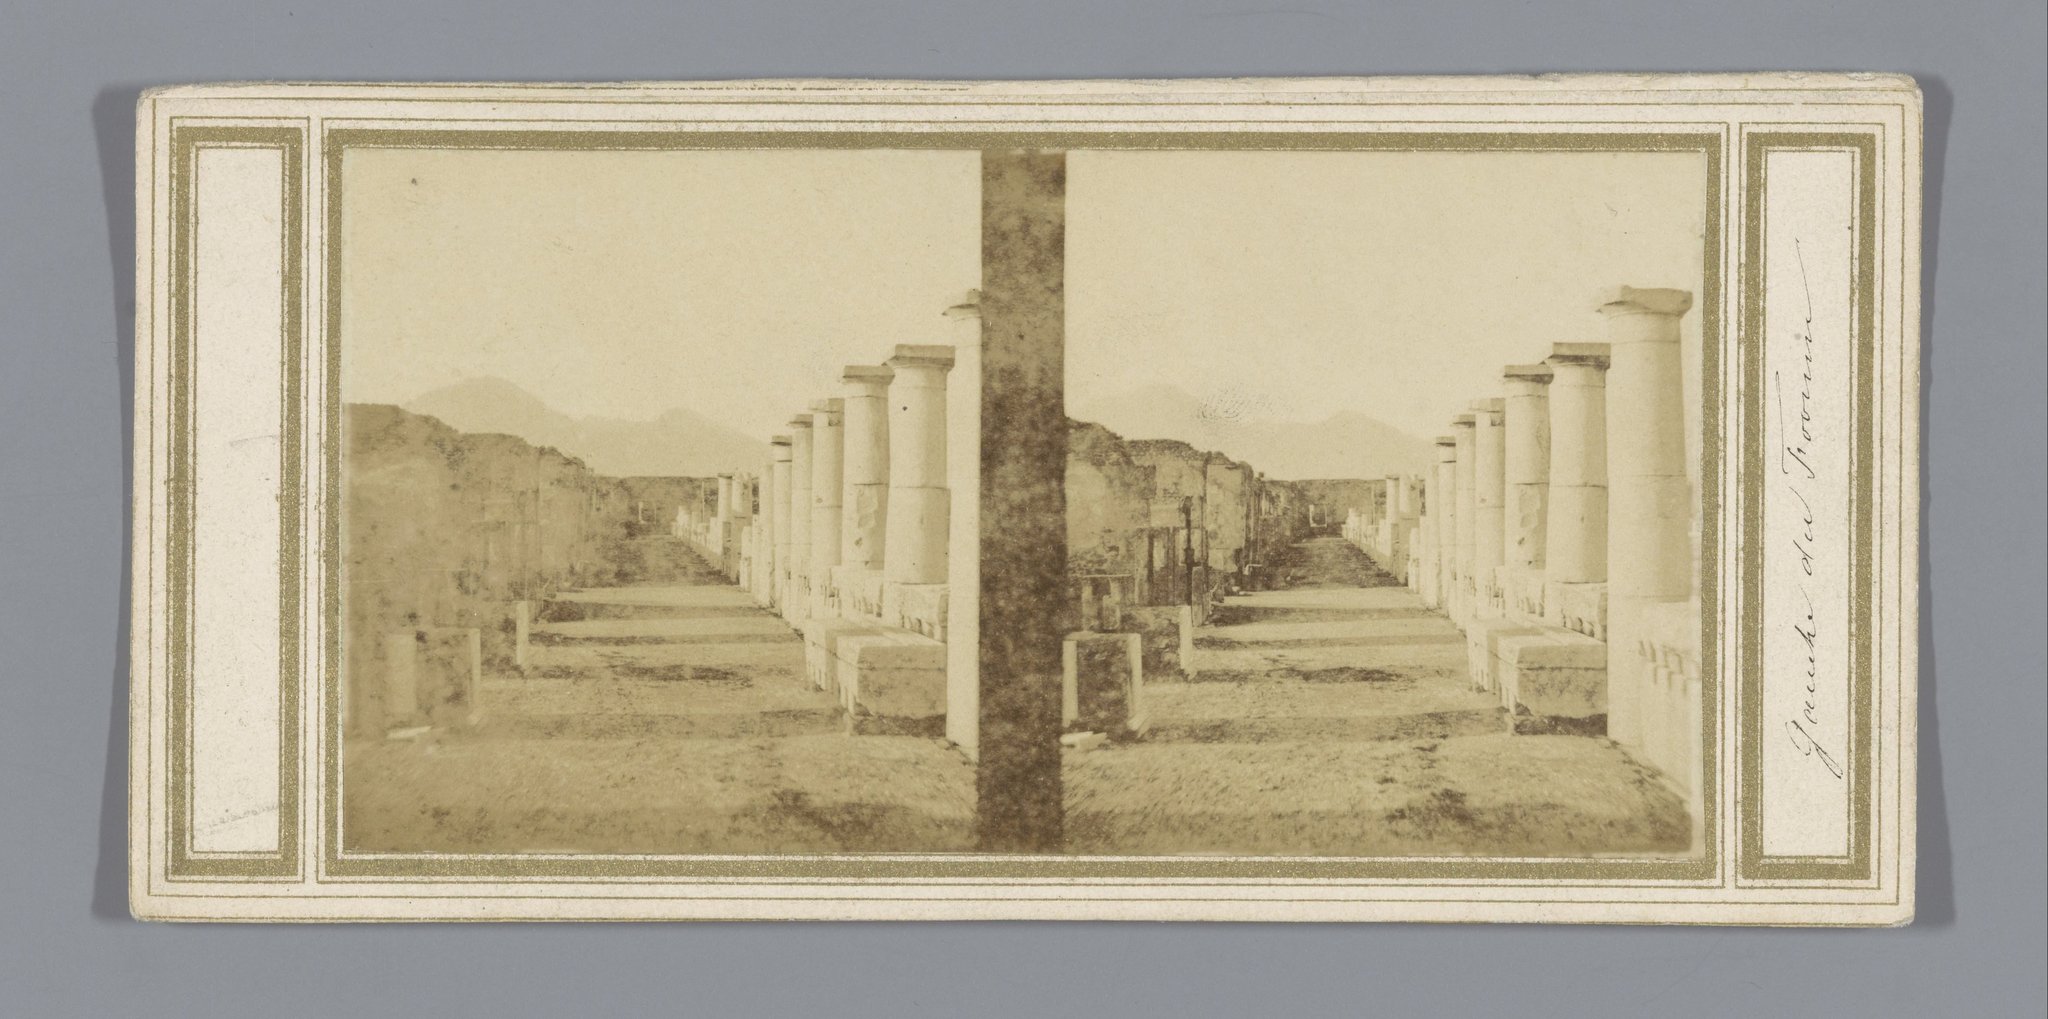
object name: stereograph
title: Zuilenrij (vermoedelijk) te Taormina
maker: Anonymous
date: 1850-1880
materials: cardboard, photographic support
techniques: albumen print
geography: taormina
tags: colonnade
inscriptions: inscription: ‘TOARMINA’